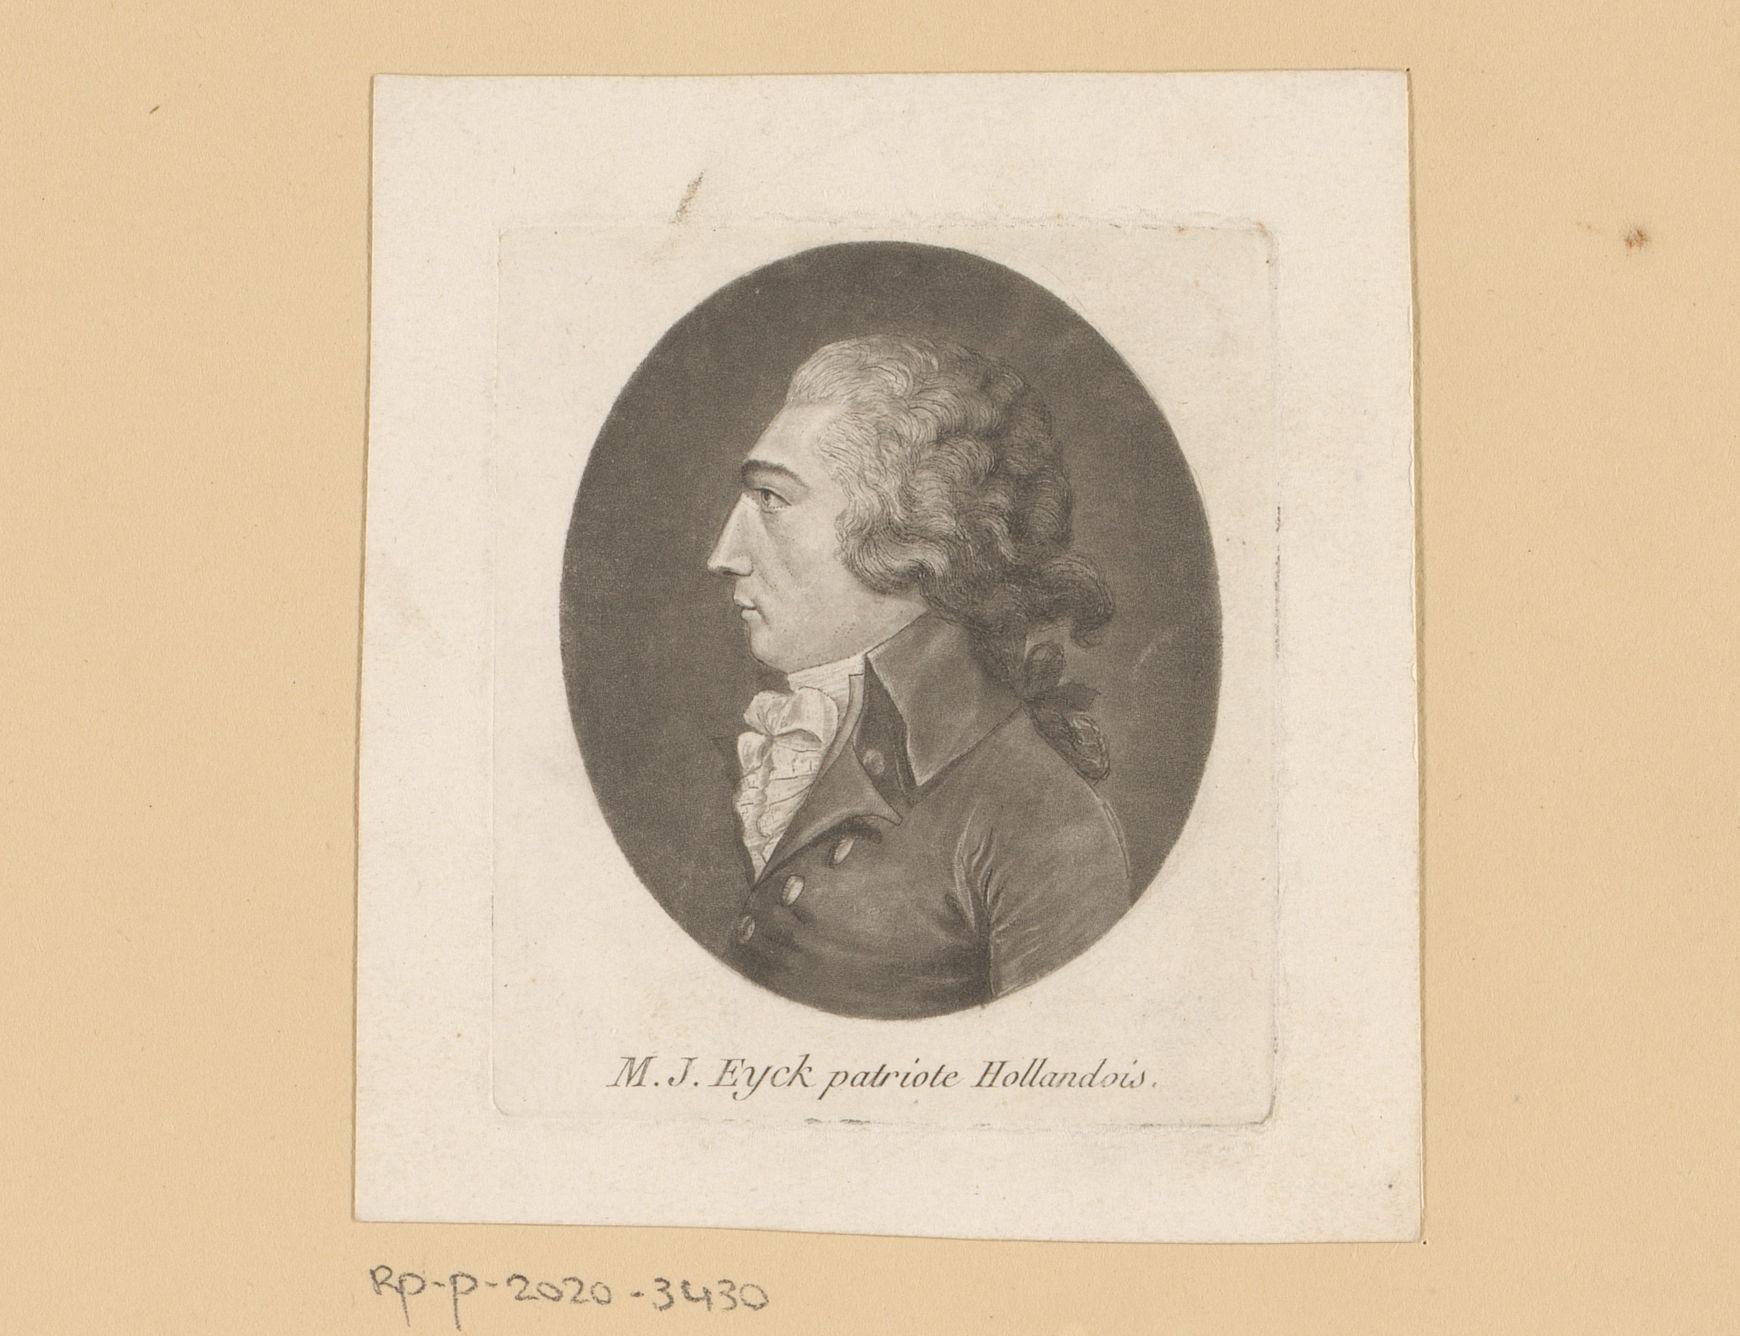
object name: print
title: M.J. Eyck patriote Hollandois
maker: edme quenedey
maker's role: print maker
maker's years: 1756-1830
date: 1785-1853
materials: paper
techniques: aquatint, etching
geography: paris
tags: silhouette-apparatus, 'physionotrace', historical persons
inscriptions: collector's mark: Lugt 2227, annotation: ‘Coll. Fr.’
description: Deze prent heeft het nummer M.95 in het fonds van Quenedey.